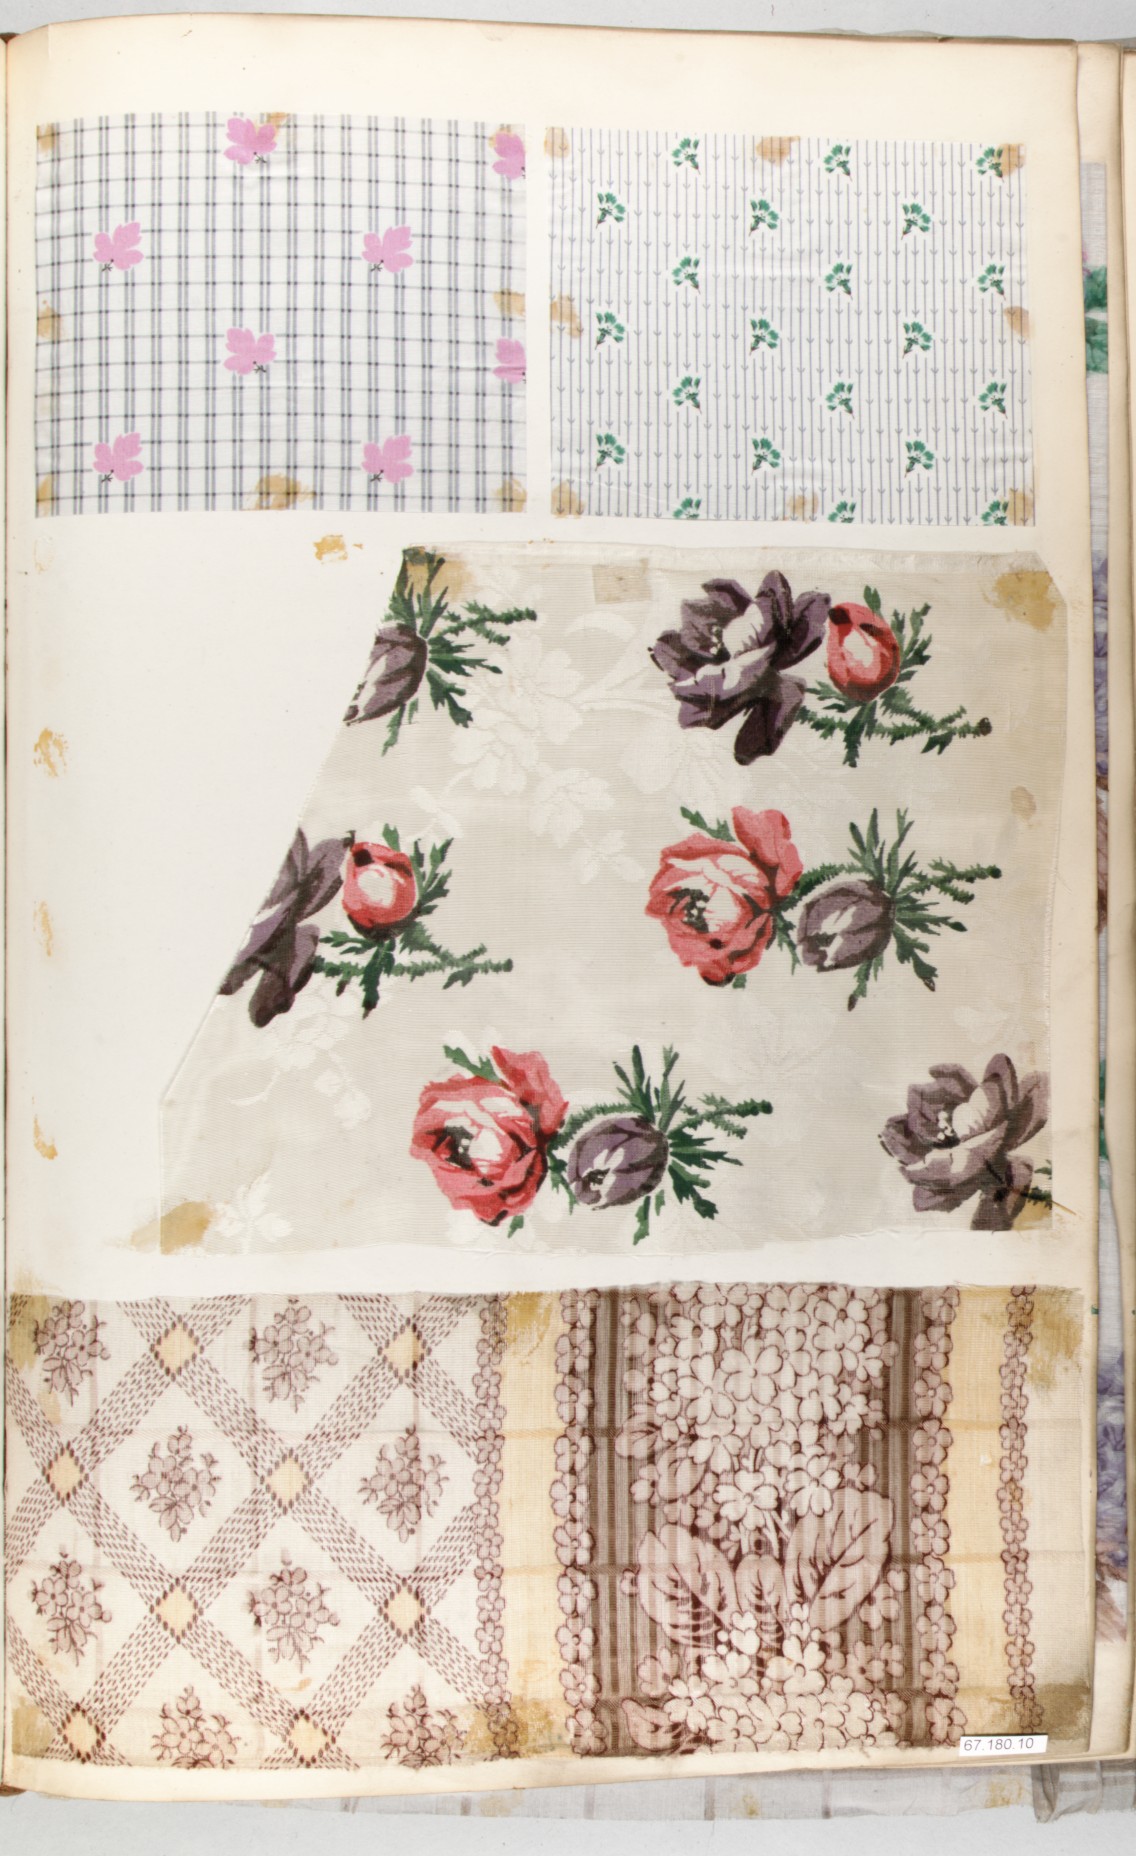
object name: sample book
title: Textile Sample Book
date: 1862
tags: flowers